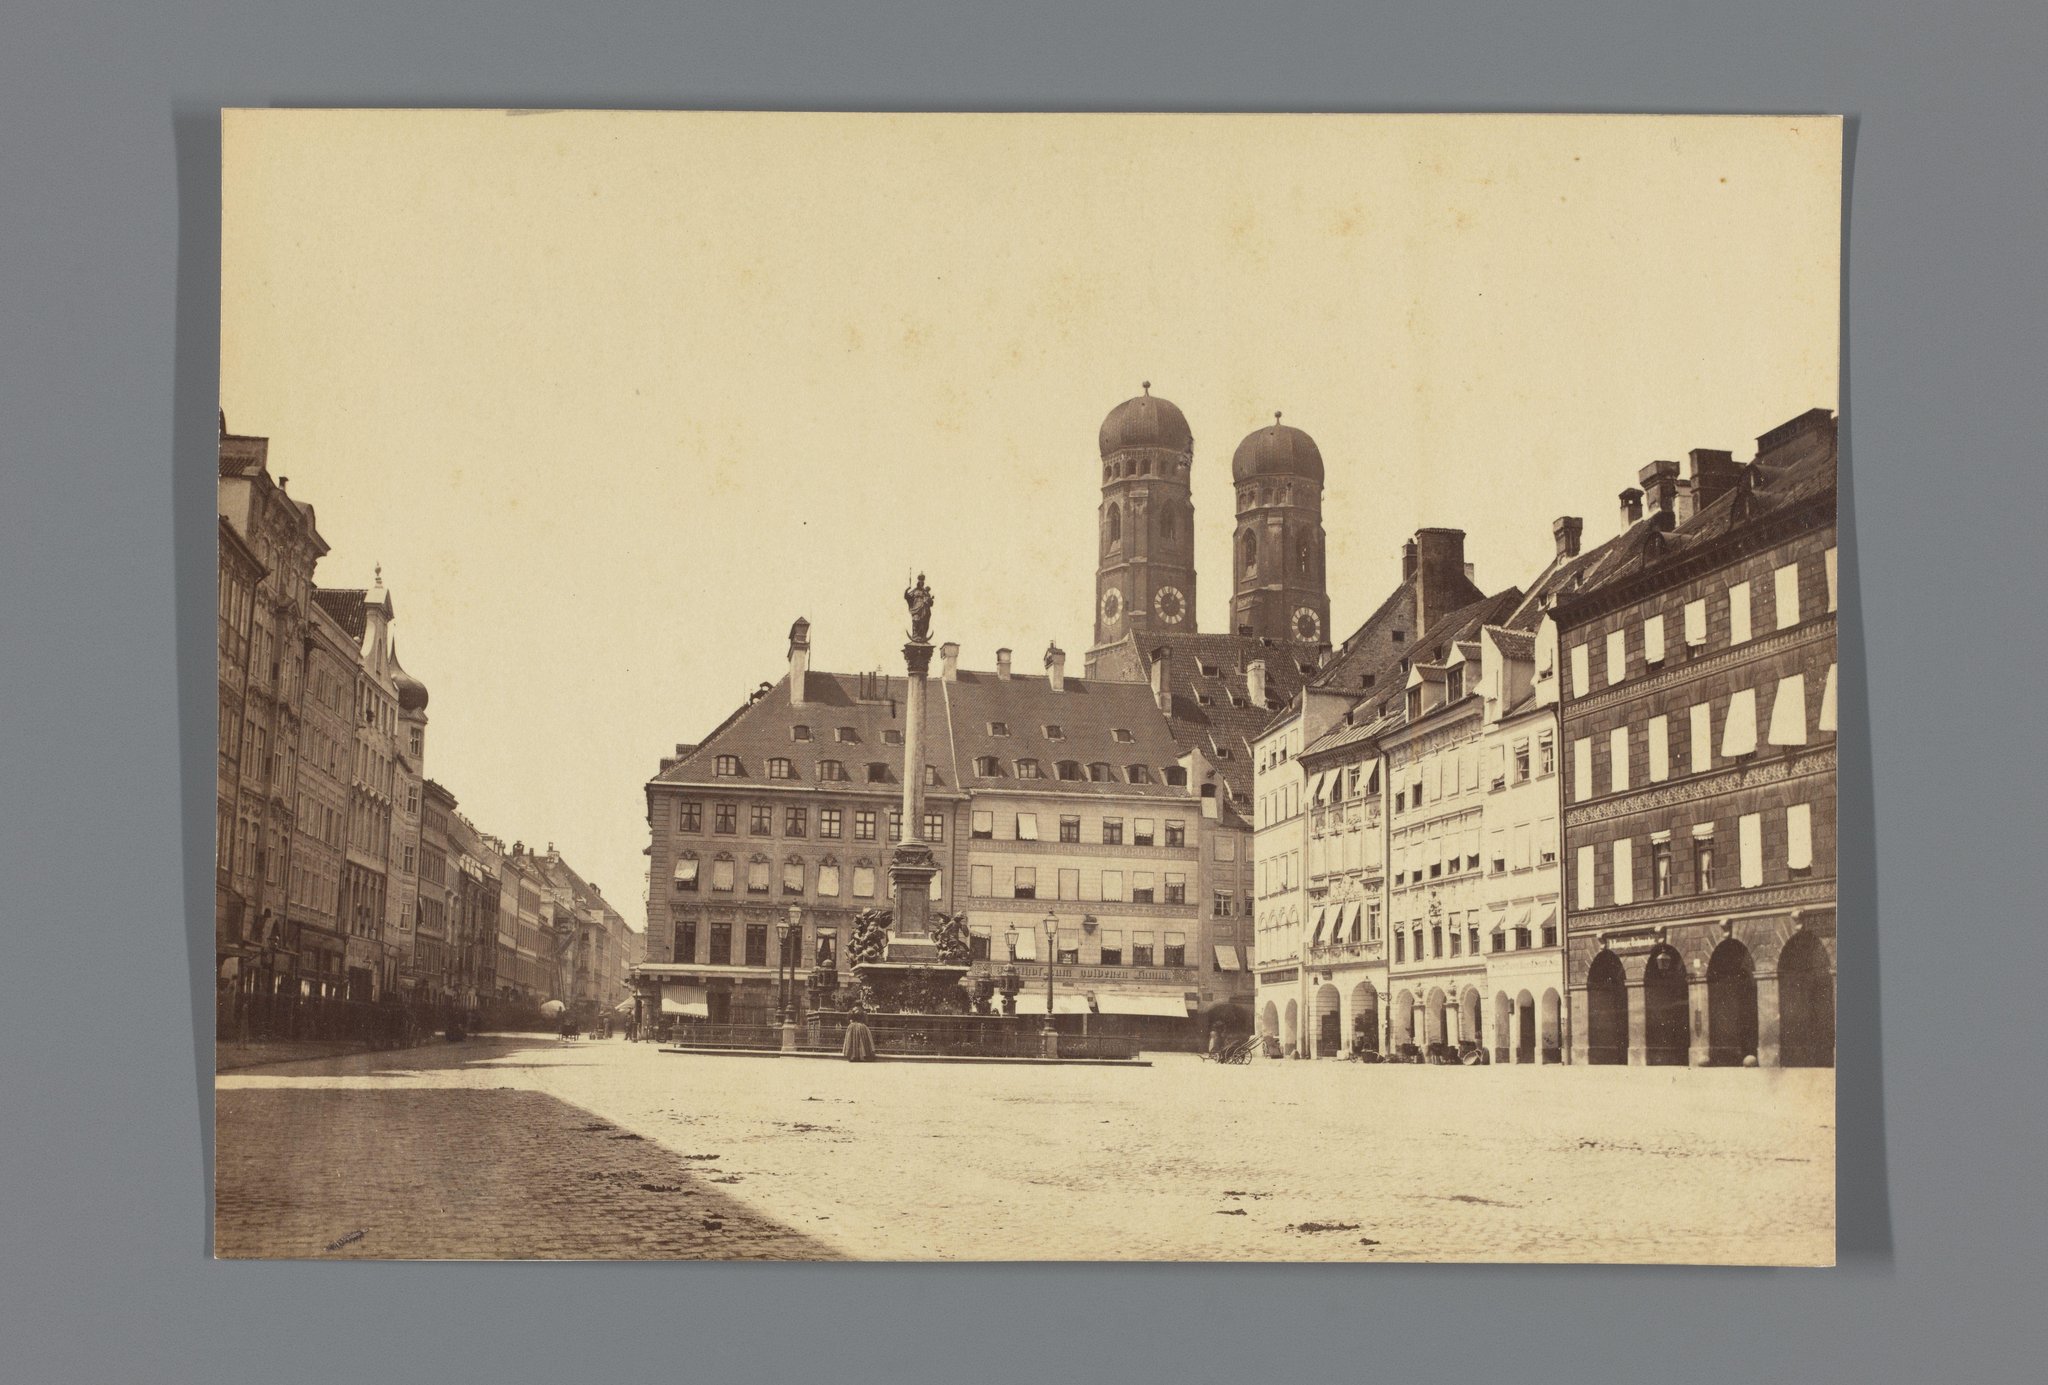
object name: photograph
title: Marienplatz München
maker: Anonymous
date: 1850-1900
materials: photographic support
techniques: albumen print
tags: marienplatz